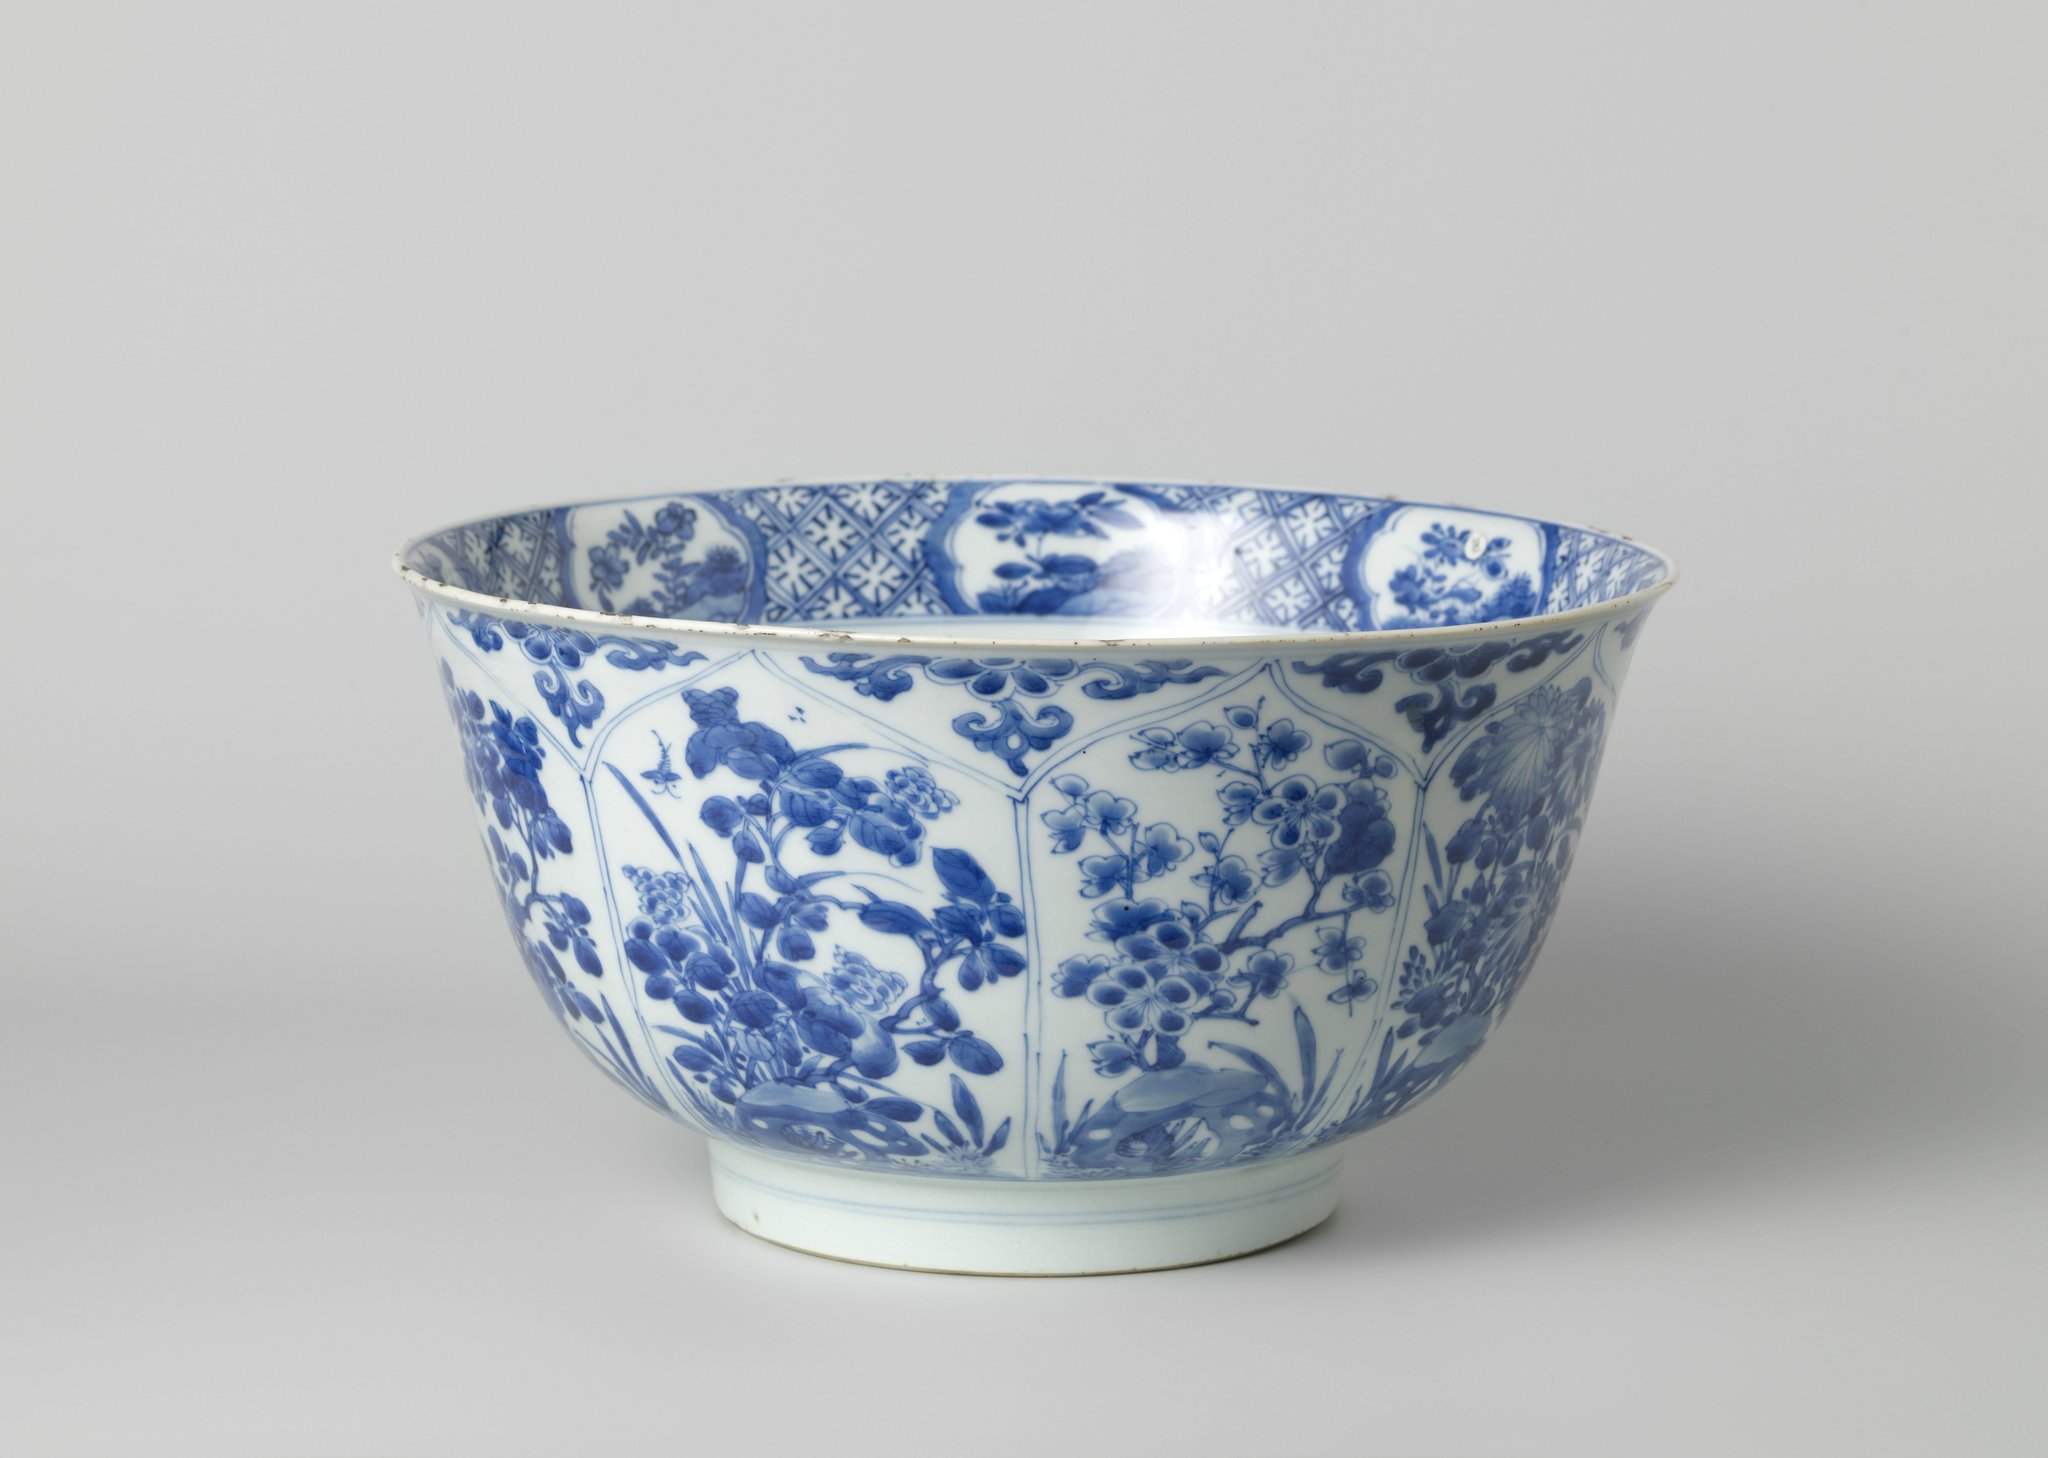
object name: bowl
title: Bowl with lotuspetal-shaped panels with flower sprays, rocks and insects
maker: Anonymous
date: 1680-1720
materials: cobalt, glaze, paint, porcelain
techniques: firing, turning, vitrification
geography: china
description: Bowl, porcelain China, Kangxi-type, 1662 - 1722